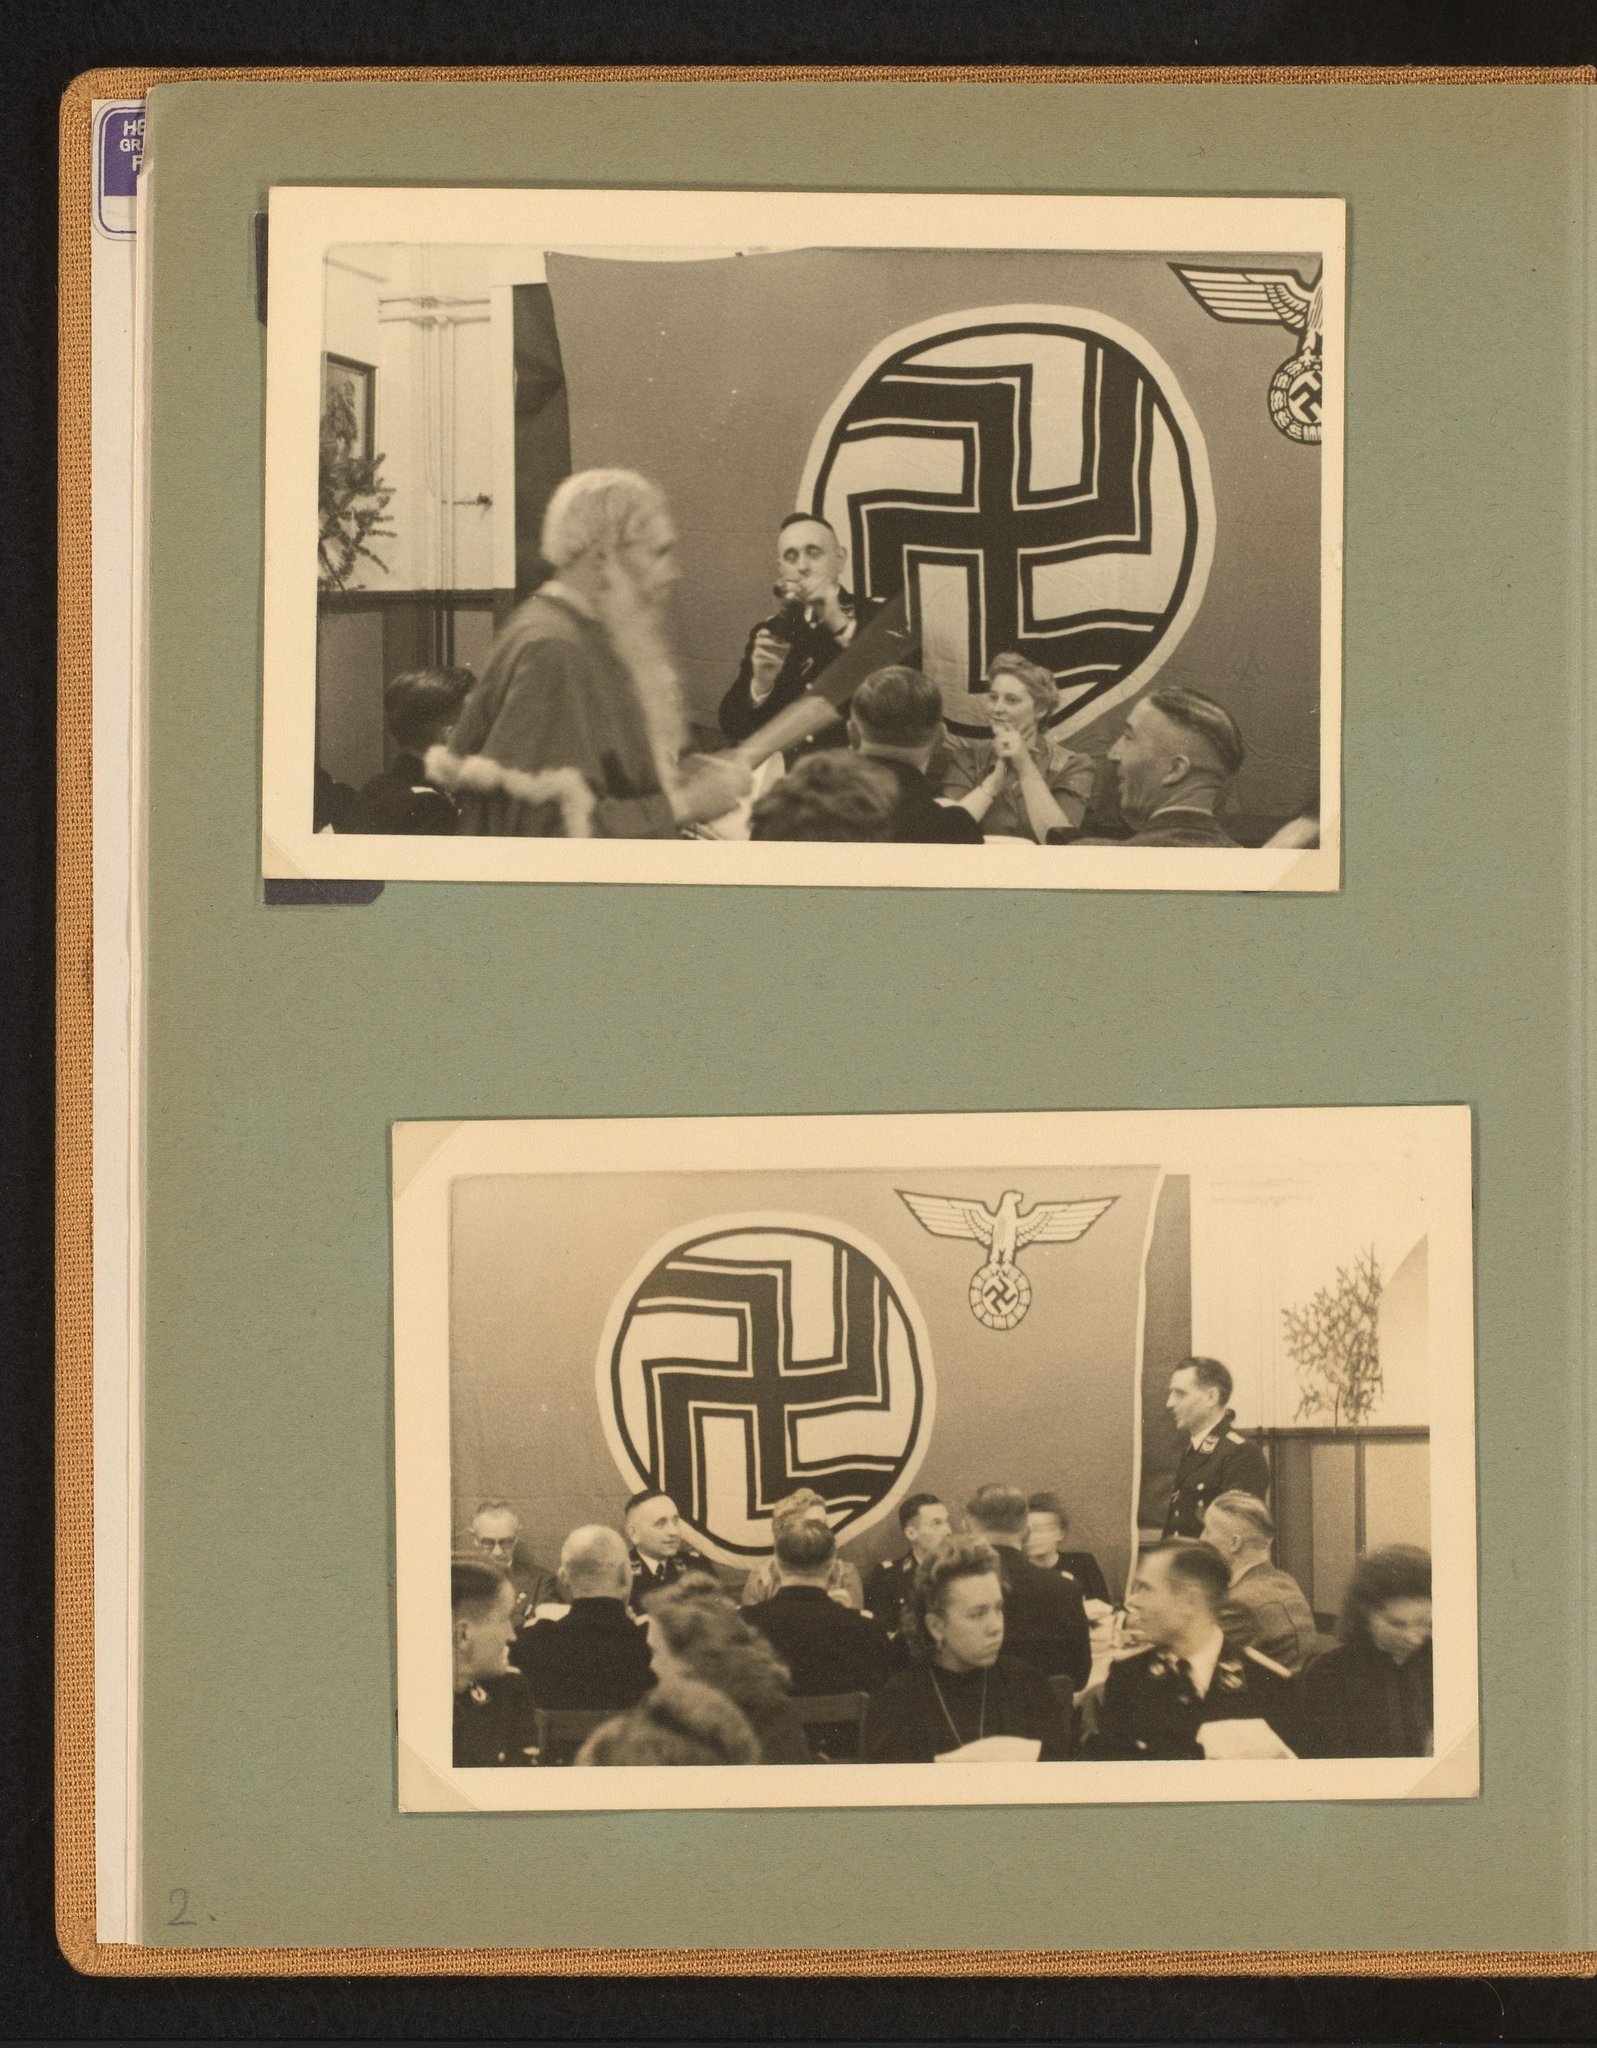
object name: album leaf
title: Kerstfeest bij de Reichsbahn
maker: Anonymous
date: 1943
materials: cardboard, photographic support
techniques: gelatin silver print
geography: utrecht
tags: christmas (non-liturgical celebration), utrecht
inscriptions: inscription: ‘Weihnachtsfeier (Kameradschaftsabend) am 17.12.1943 beim Bbo Utrecht’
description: Albumblad met twee foto's van de viering van het kerstfeest bij de Deutsche Reichsbahn op 17 december 1943. De bovenste foto met een kerstman en een Duitser met een fototoestel, op de onderste foto zitten aanwezigen aan tafel luisterend naar een toespraak. Beide foto's hebben achter aan de muur de hakenkruisvlag met adelaar en het symbool van de spoorwegen. Waarschijnlijk in de Stadsschouwburg te Utrecht. Onderdeel van het fotoalbum Deutsche Reichsbahn, 1943-1944.